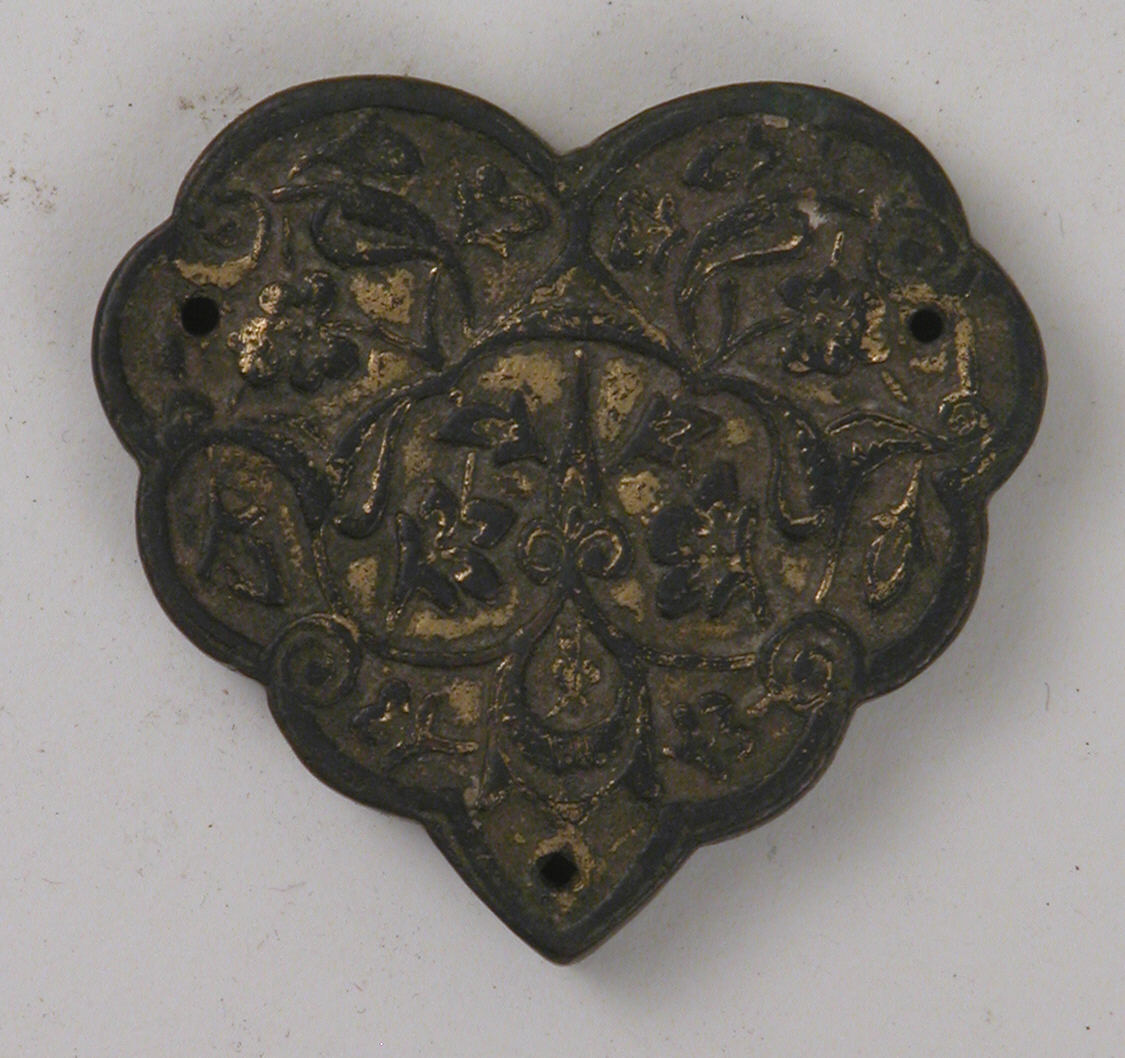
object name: plaque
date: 1501-1600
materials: bronze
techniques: casting, gilding, incising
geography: iran